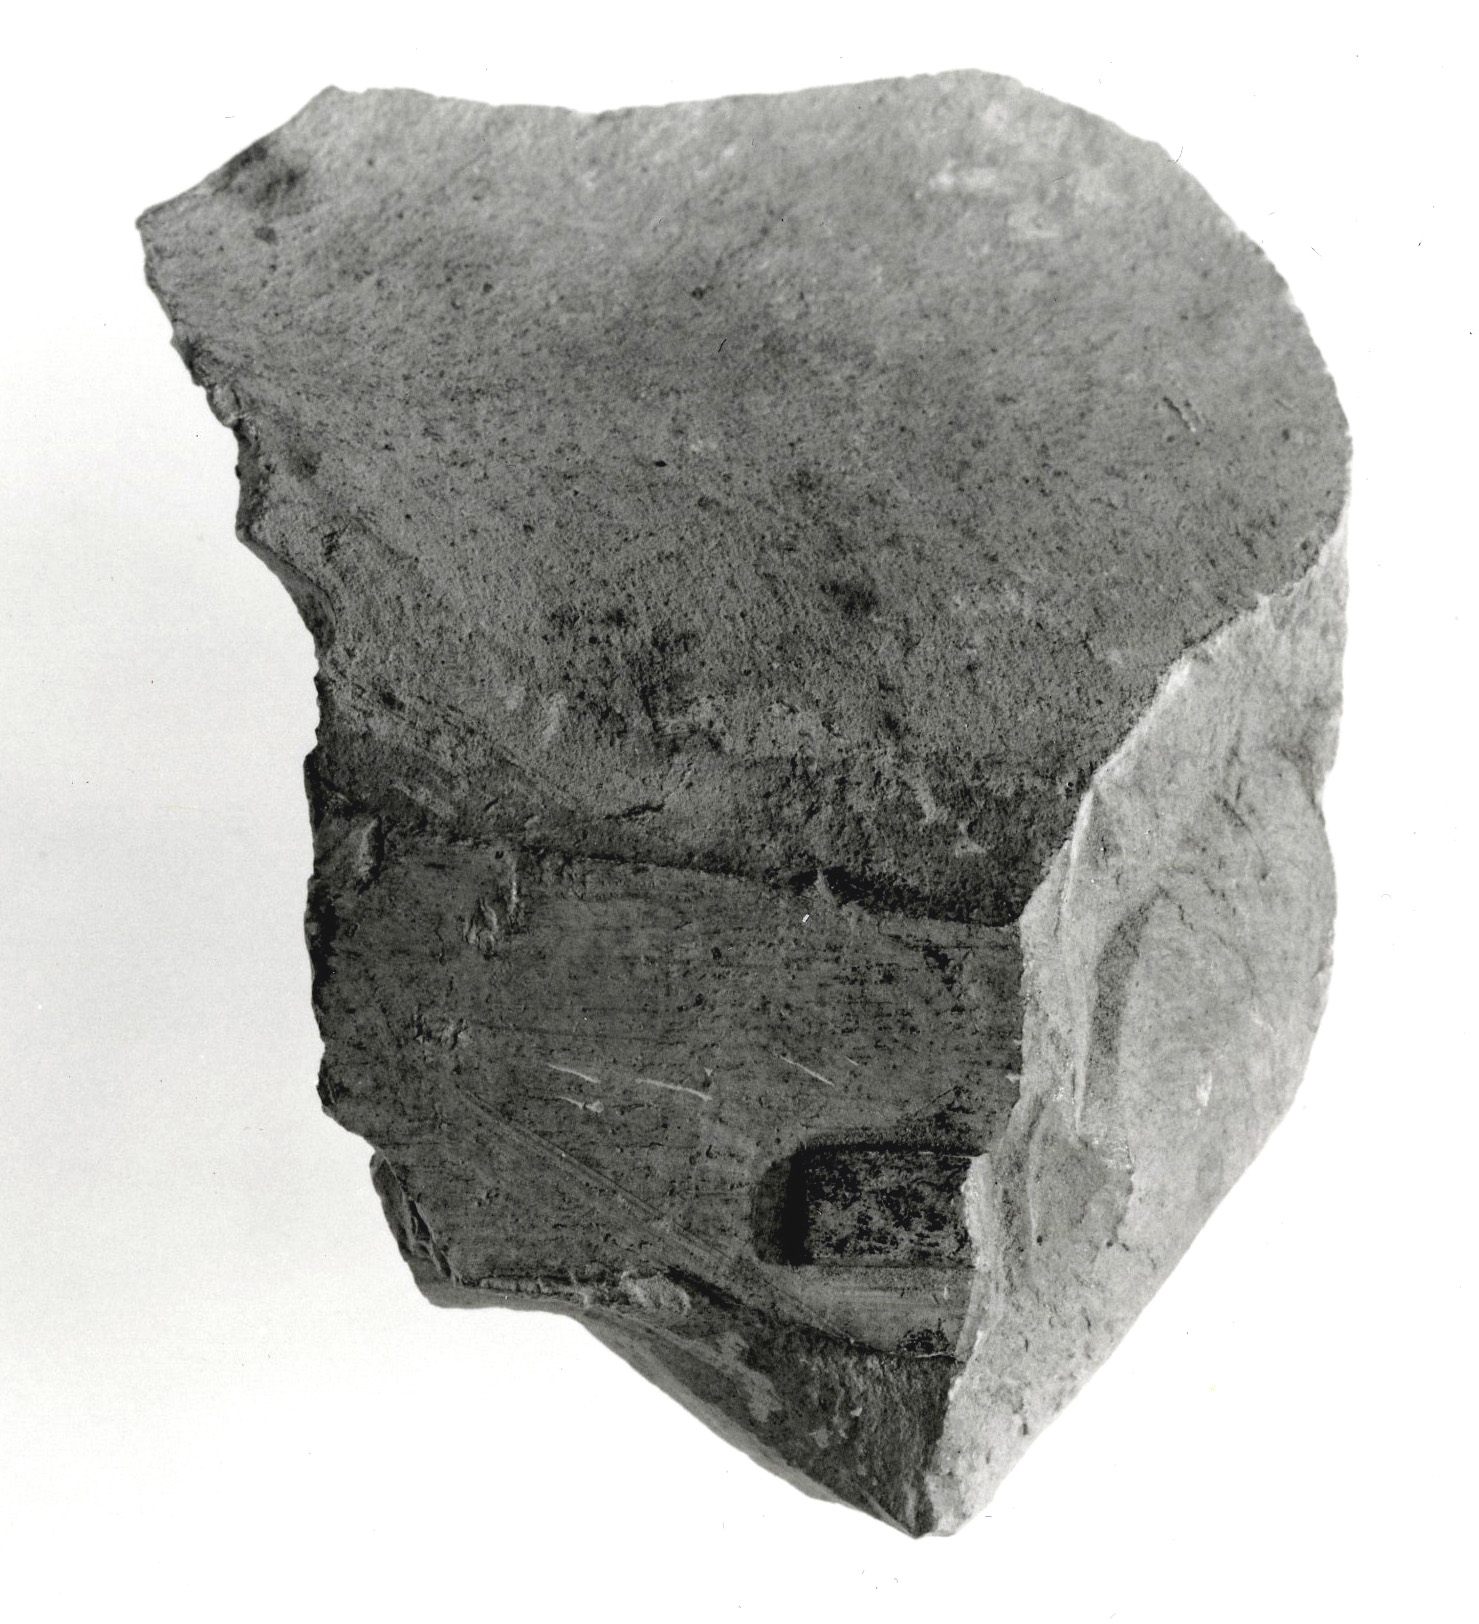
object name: relief, tomb of nespekashuty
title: Raised relief fragment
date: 664-610 BCE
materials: limestone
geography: egypt